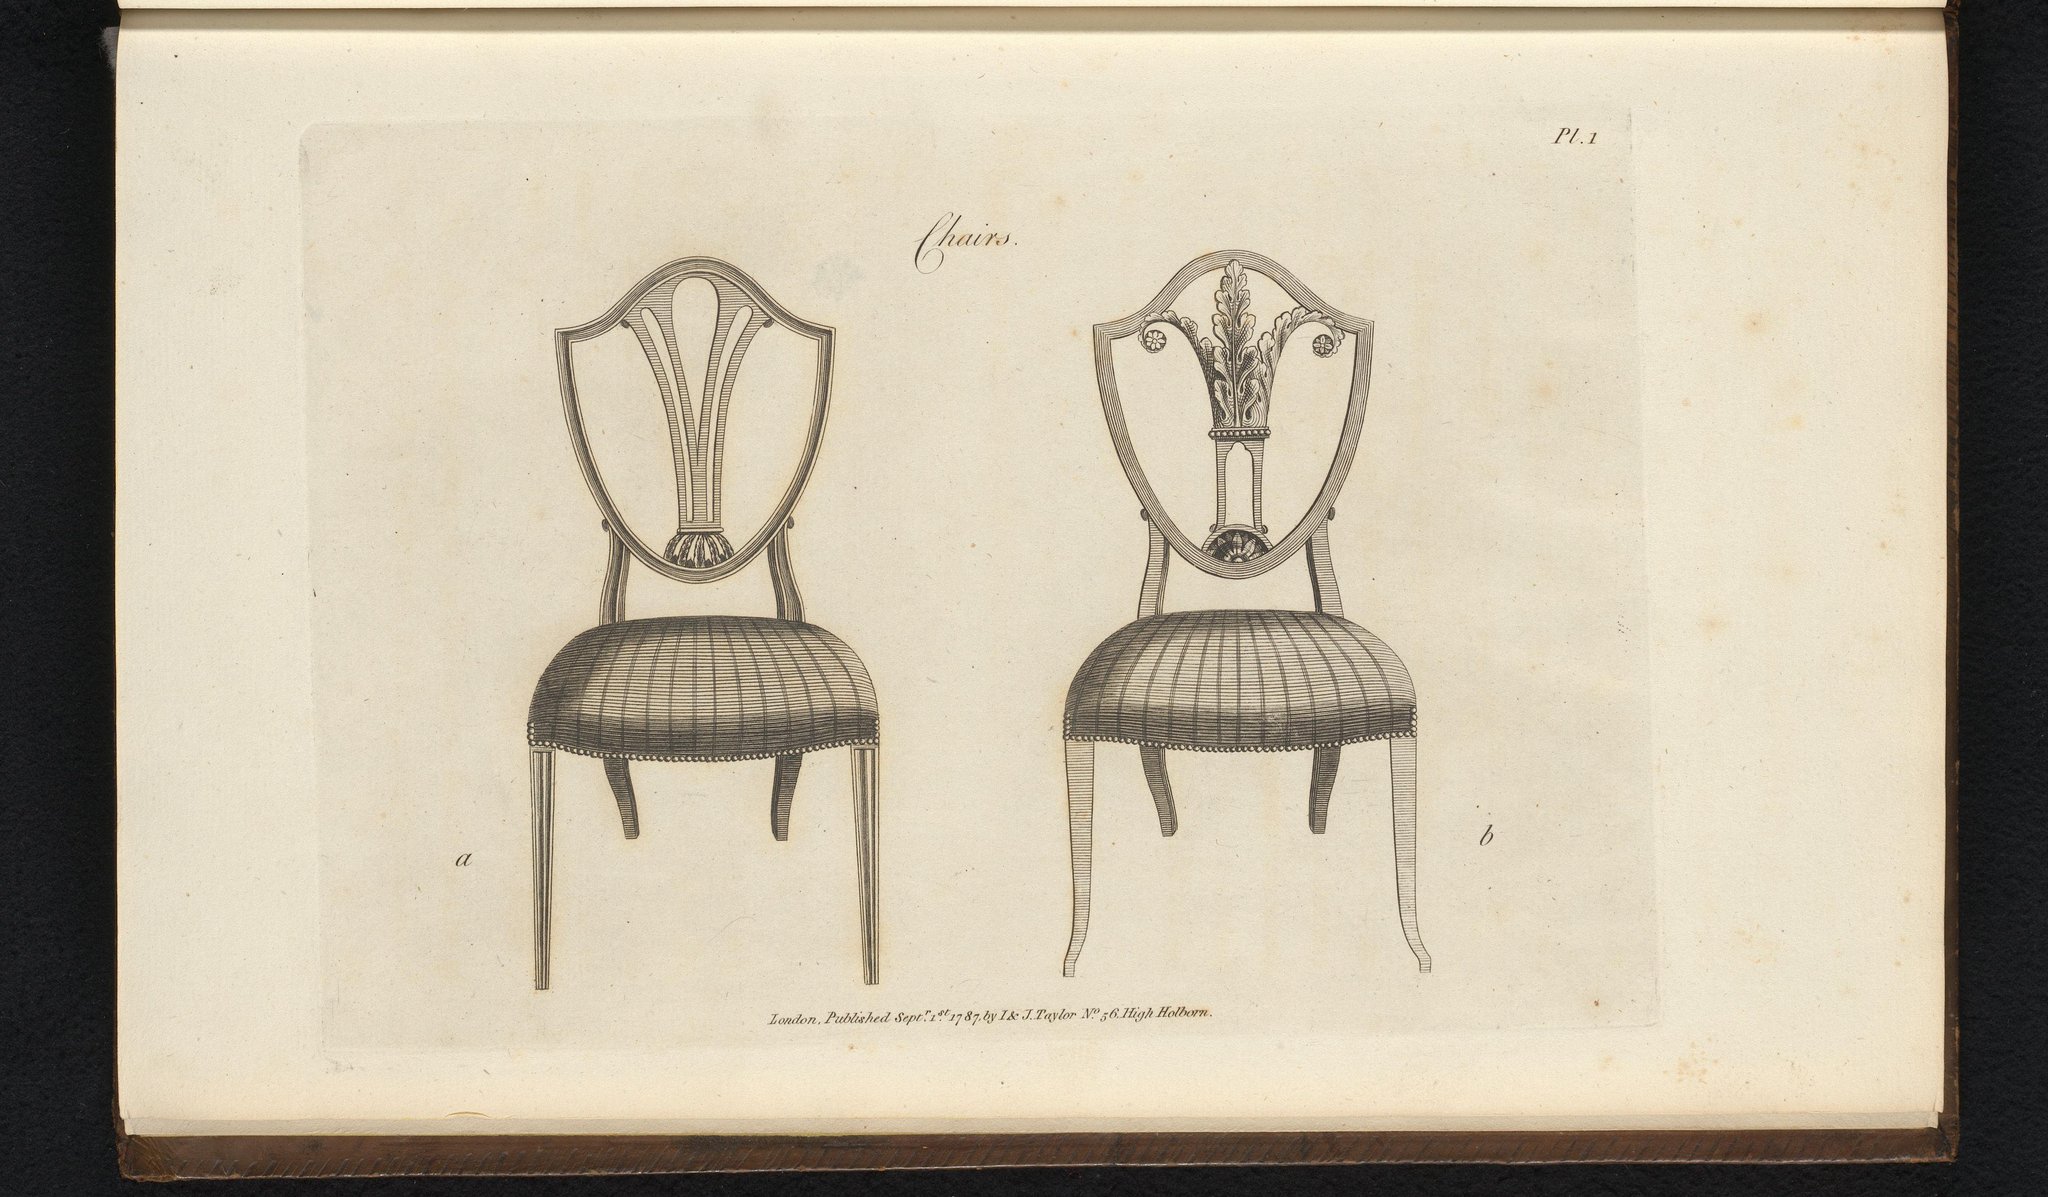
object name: page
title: Meubels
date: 1787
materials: paper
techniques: engraving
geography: holborn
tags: chair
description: Genummerd: Pl. 1. Stoelen gemerkt: a en b. Prent maakt deel uit van een boek.